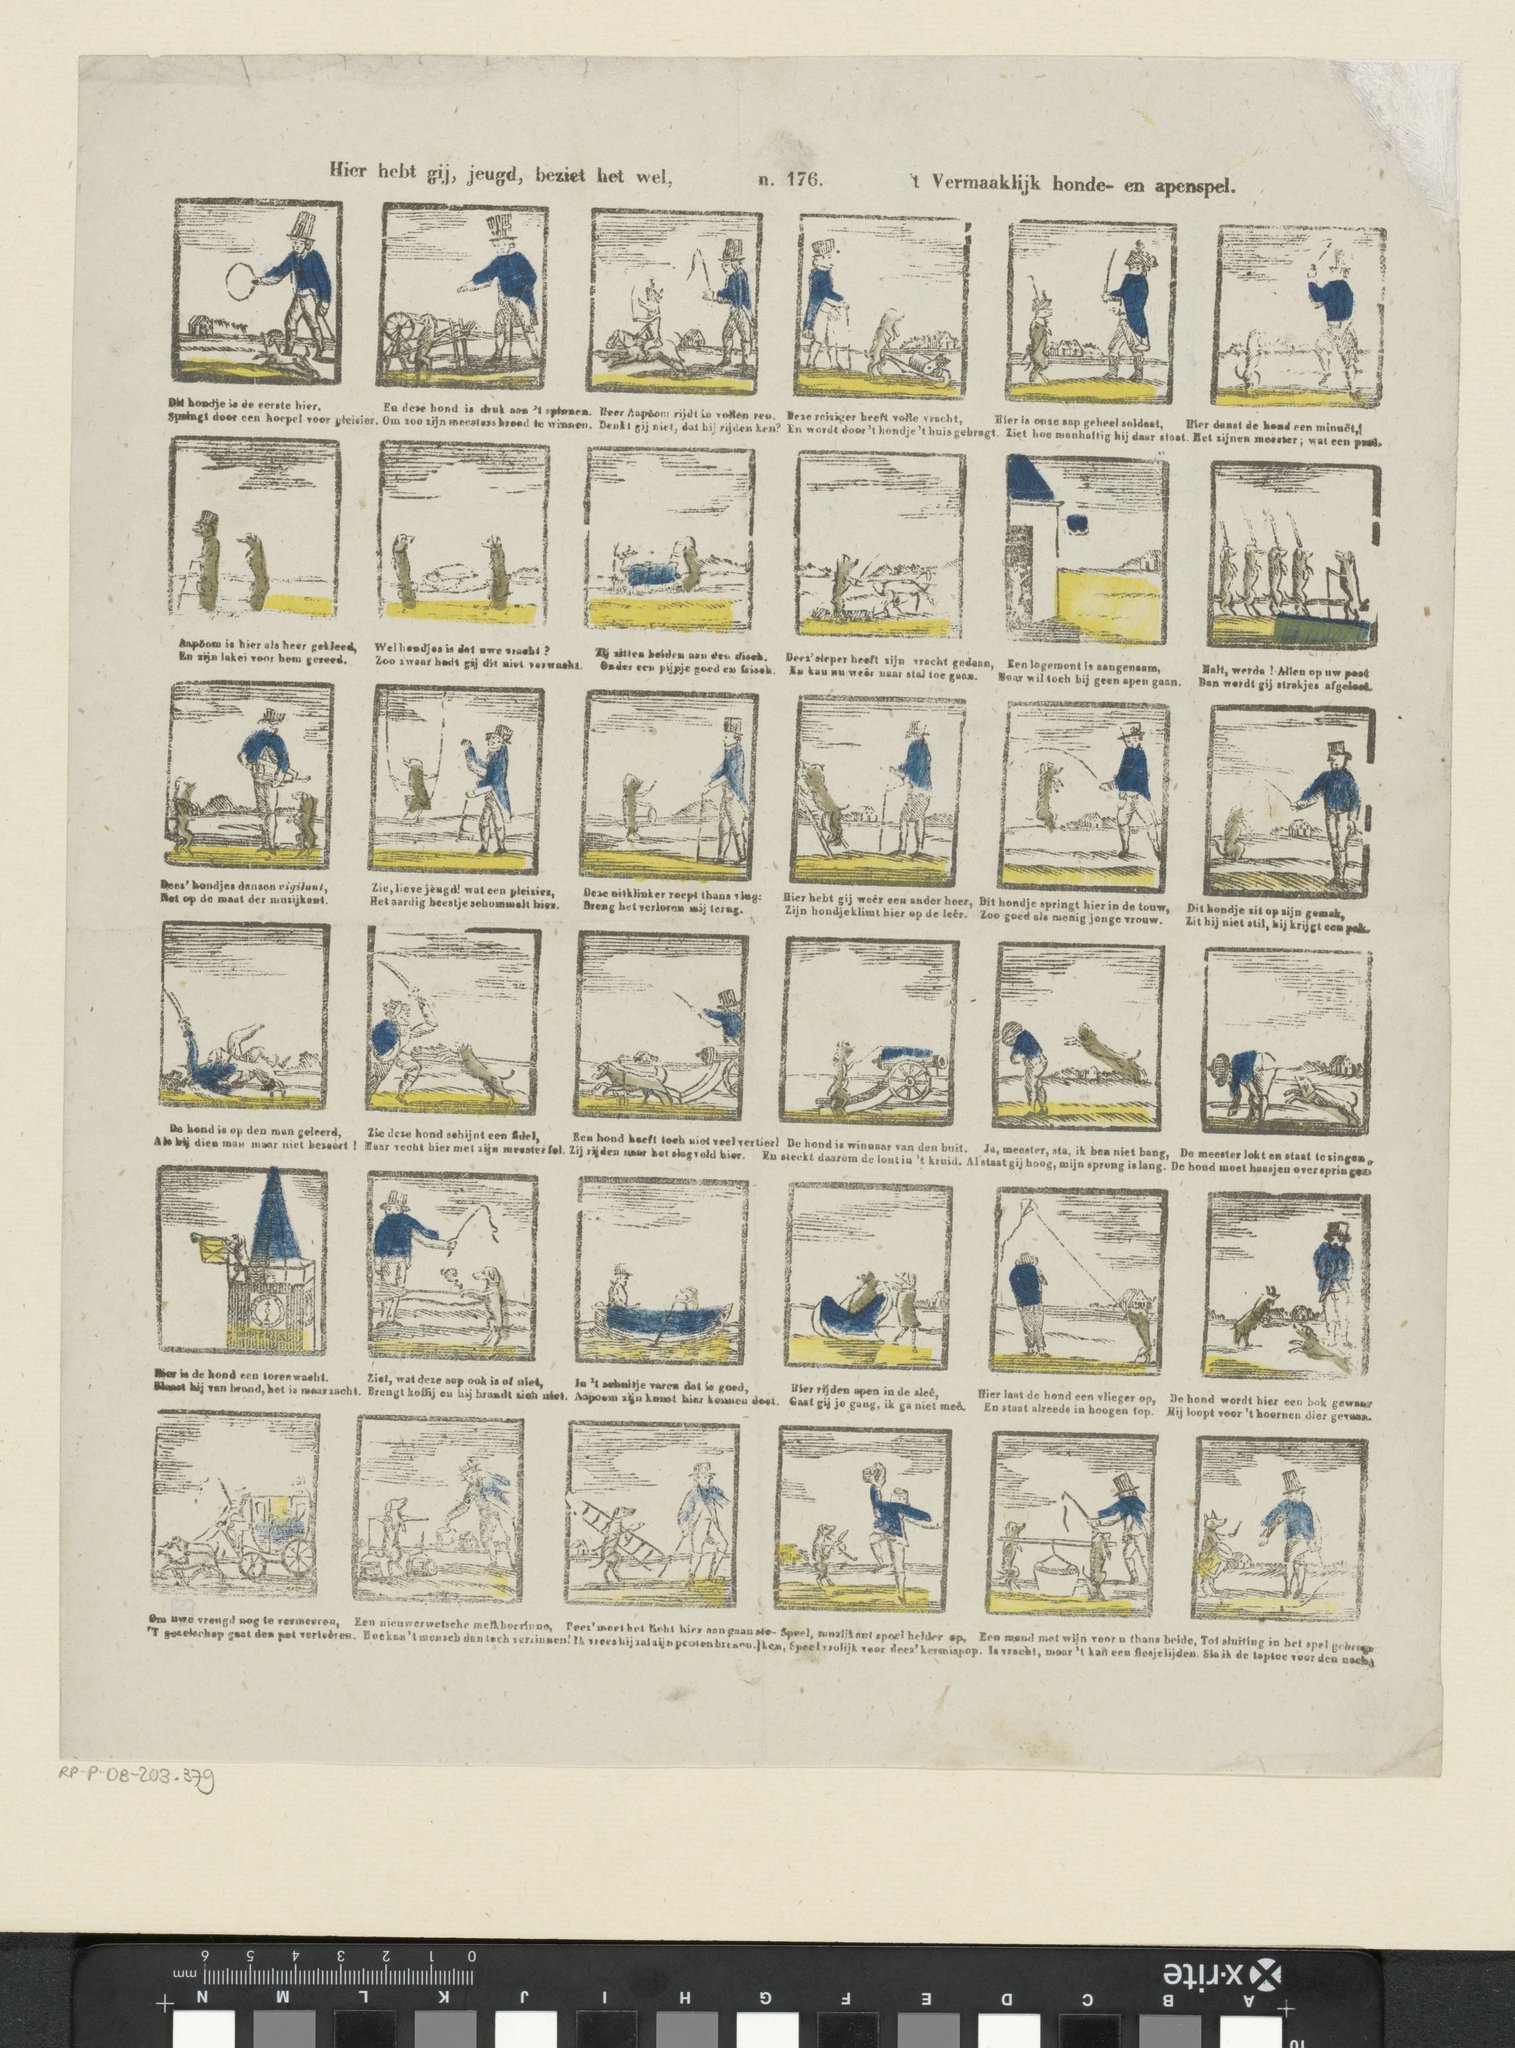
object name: popular print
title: Hier hebt gij, jeugd, beziet het wel, / 't vermaaklijk honde- en apenspel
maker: Anonymous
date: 1856-1900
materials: paper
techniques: colour, letterpress printing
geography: turnhout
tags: monkeys (circus performance), monkeys, apes, dogs (circus performance), dog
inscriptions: collector's mark: Lugt 2760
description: Blad met 36 voorstellingen van honden en apen die kunstjes doen. Onder elke afbeelding een tweeregelig vers. Genummerd midden boven: n. 176.